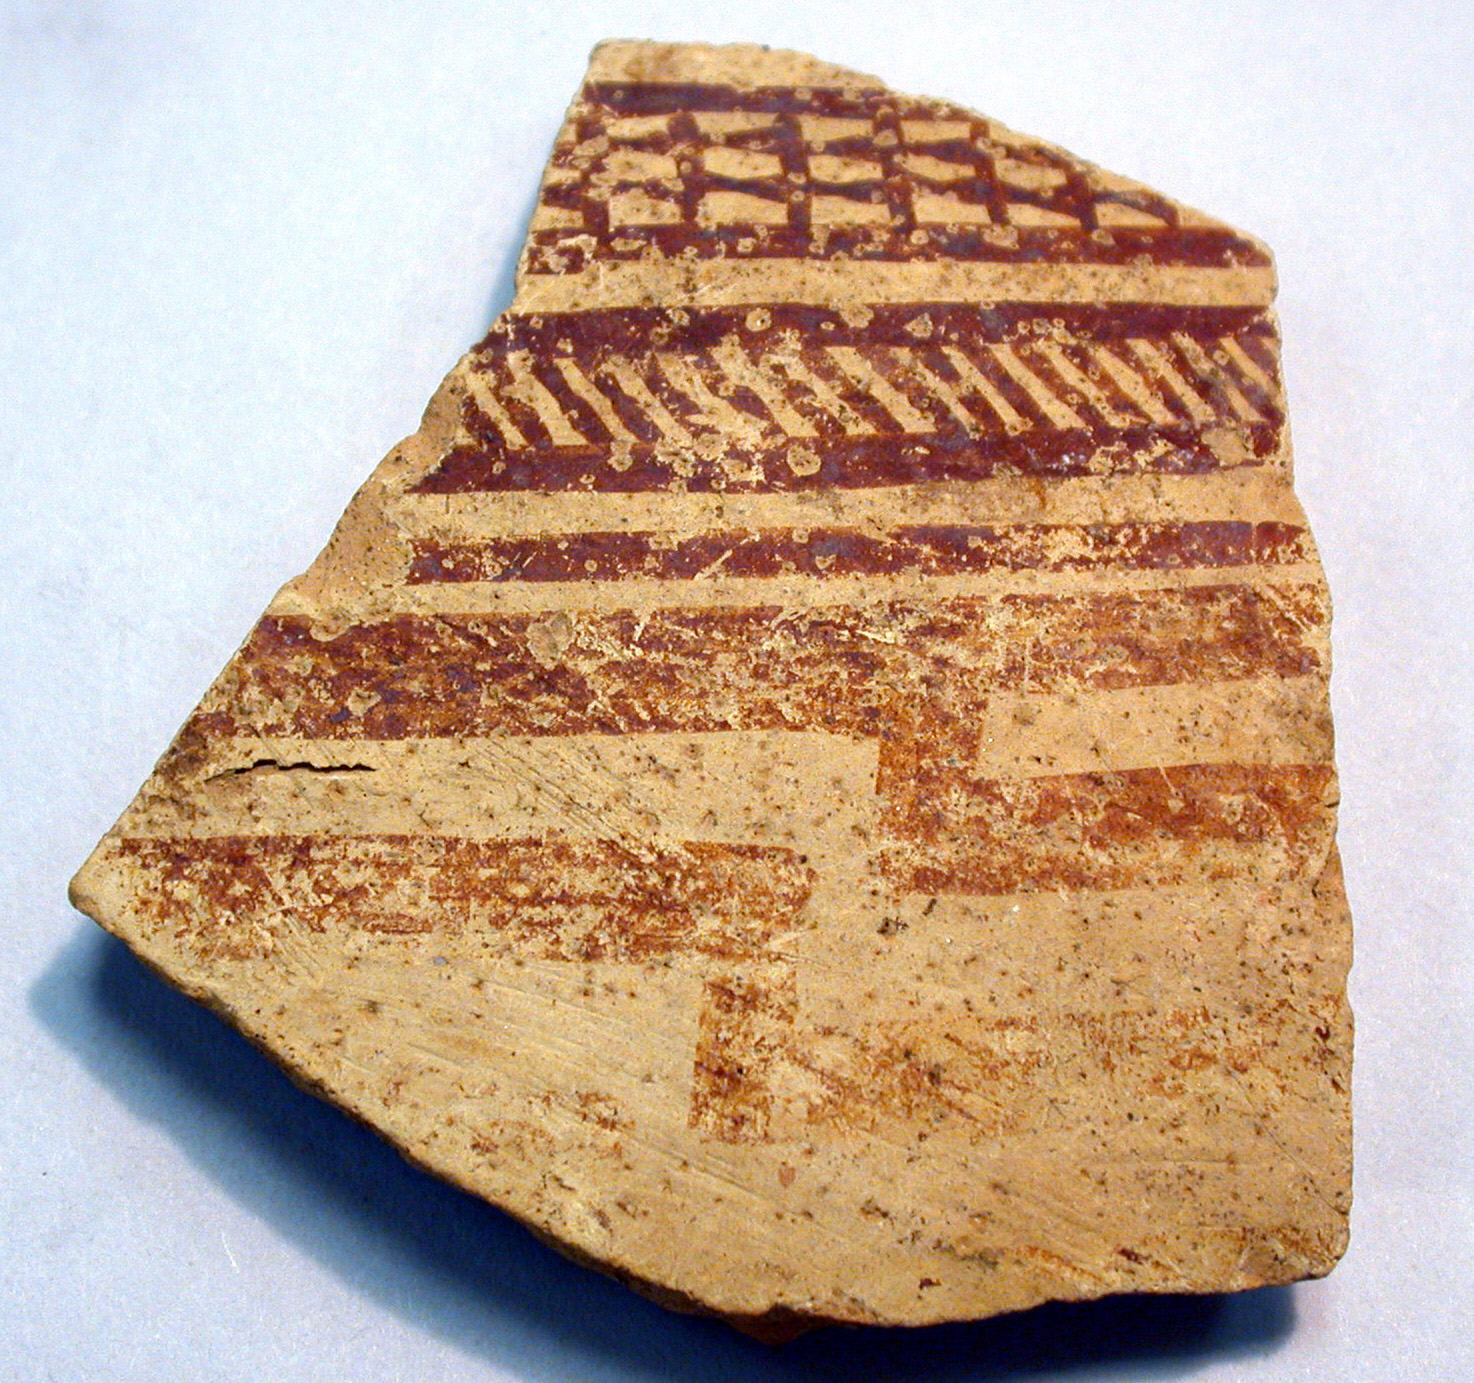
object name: sherd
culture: samarra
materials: ceramic, paint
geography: mesopotamia